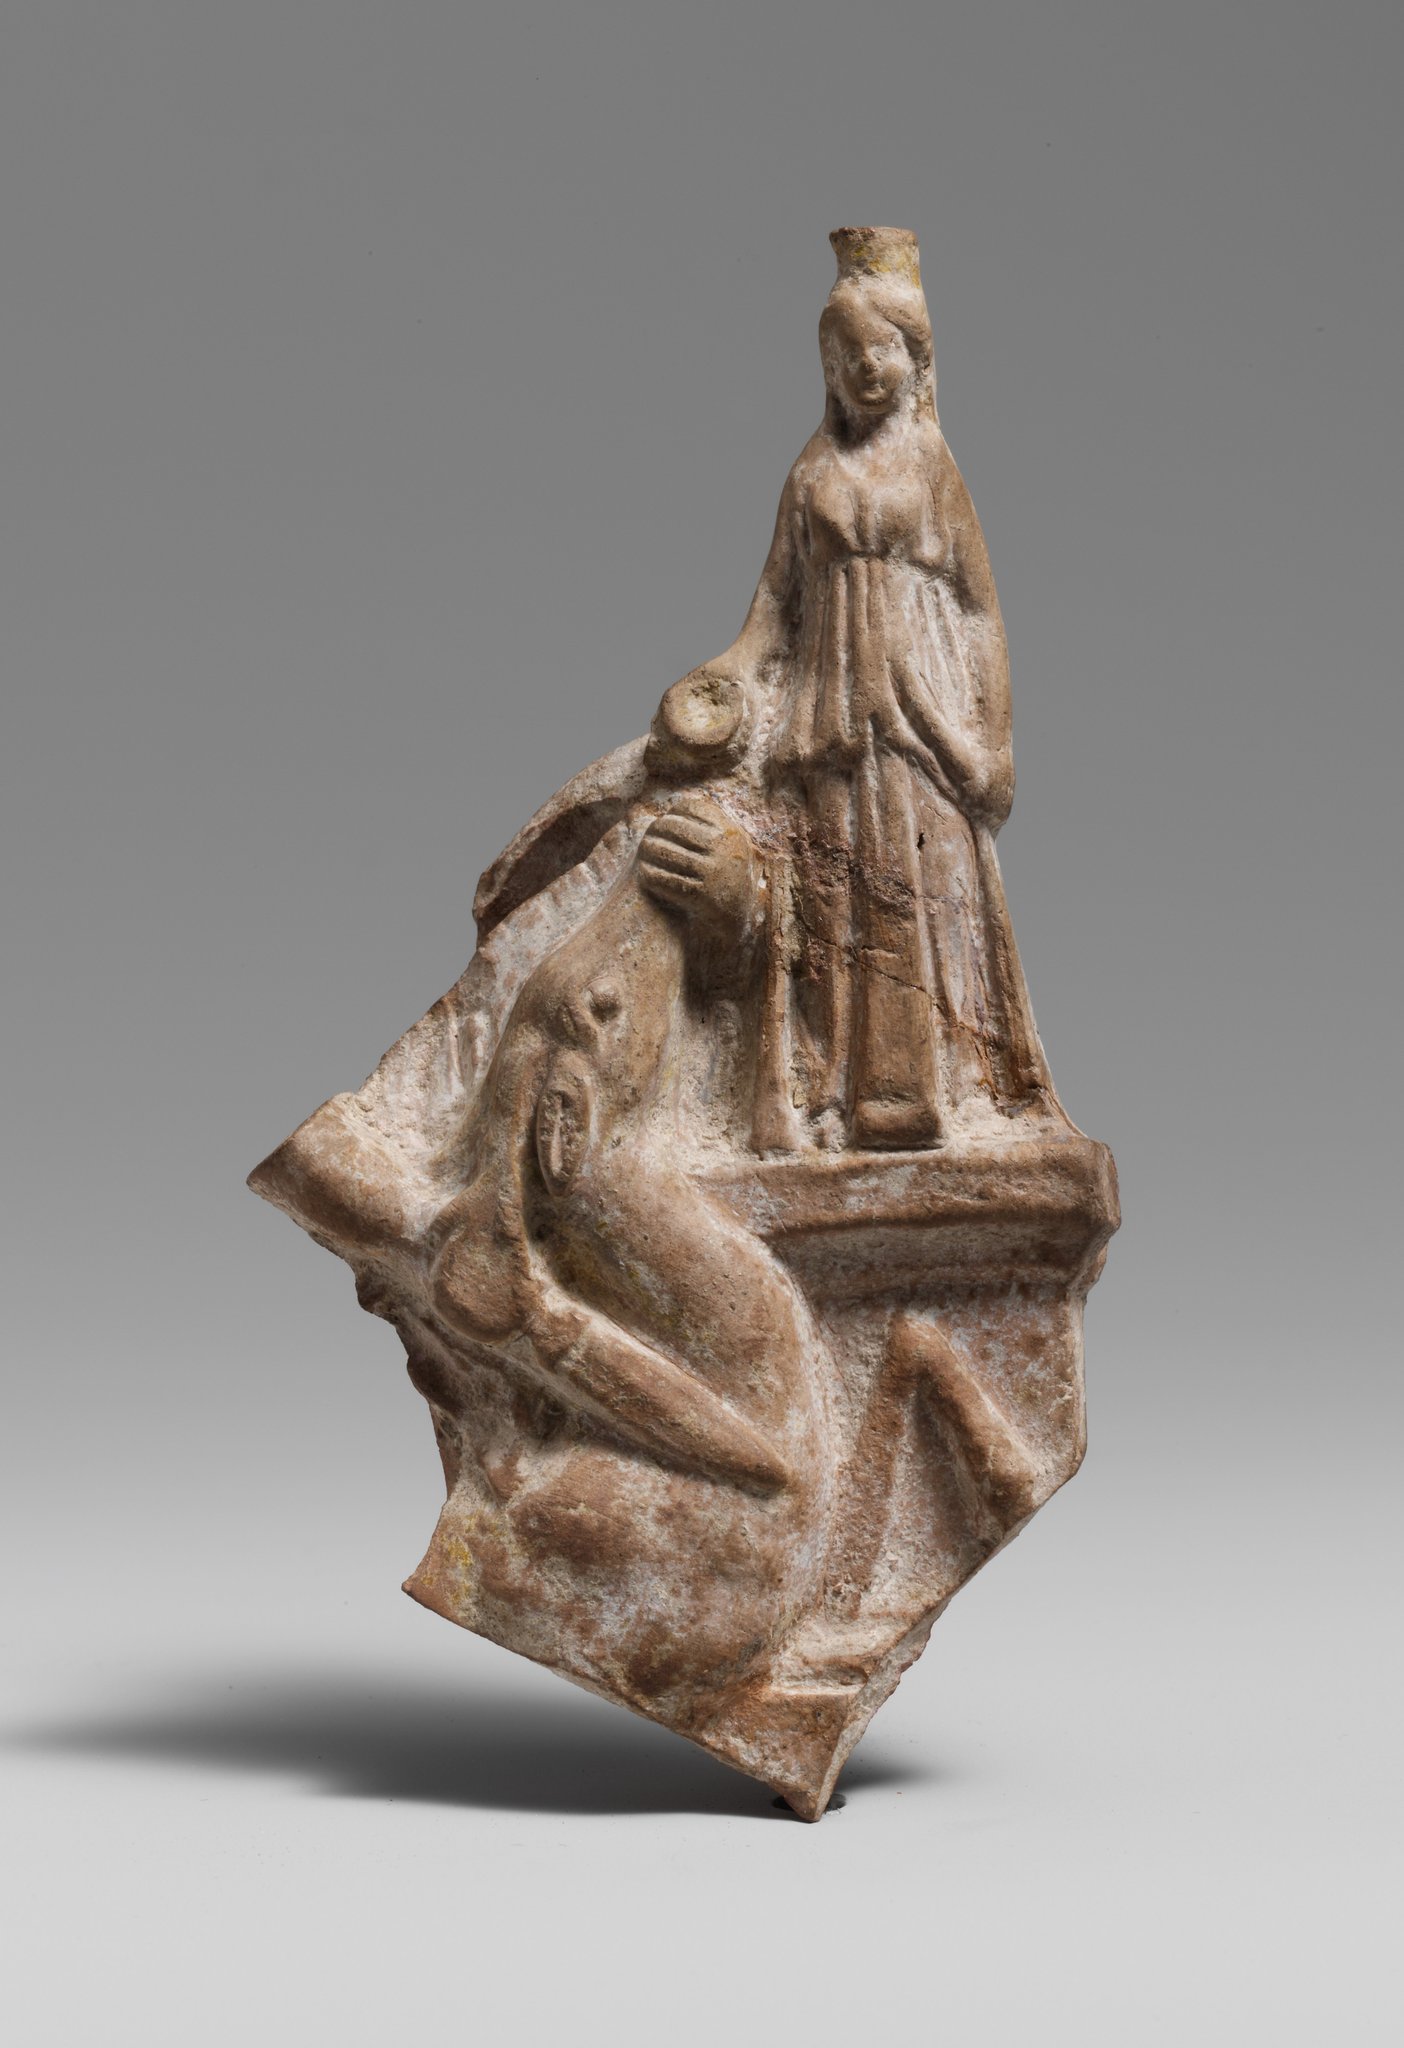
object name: statuette fragment of a deer sacrificed at an altar to artemis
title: Terracotta statuette fragment of a deer sacrificed at an altar to Artemis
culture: greek, asia minor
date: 200-101 BCE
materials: terracotta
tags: knives,artemis,eros,deer